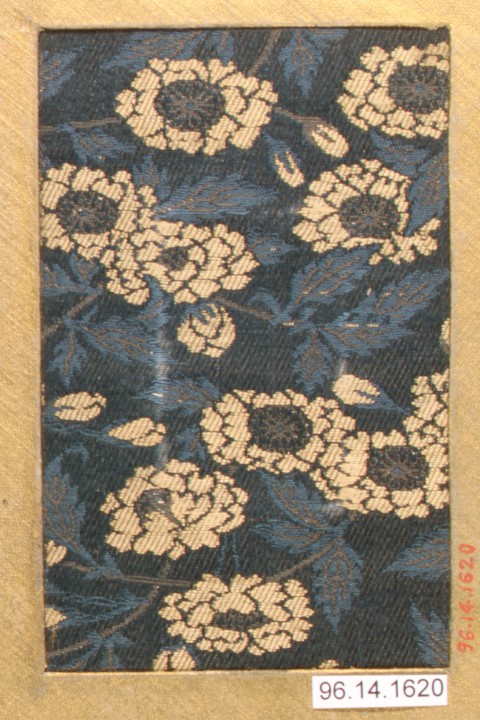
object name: piece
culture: japanese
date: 1701-1900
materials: silk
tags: flowers